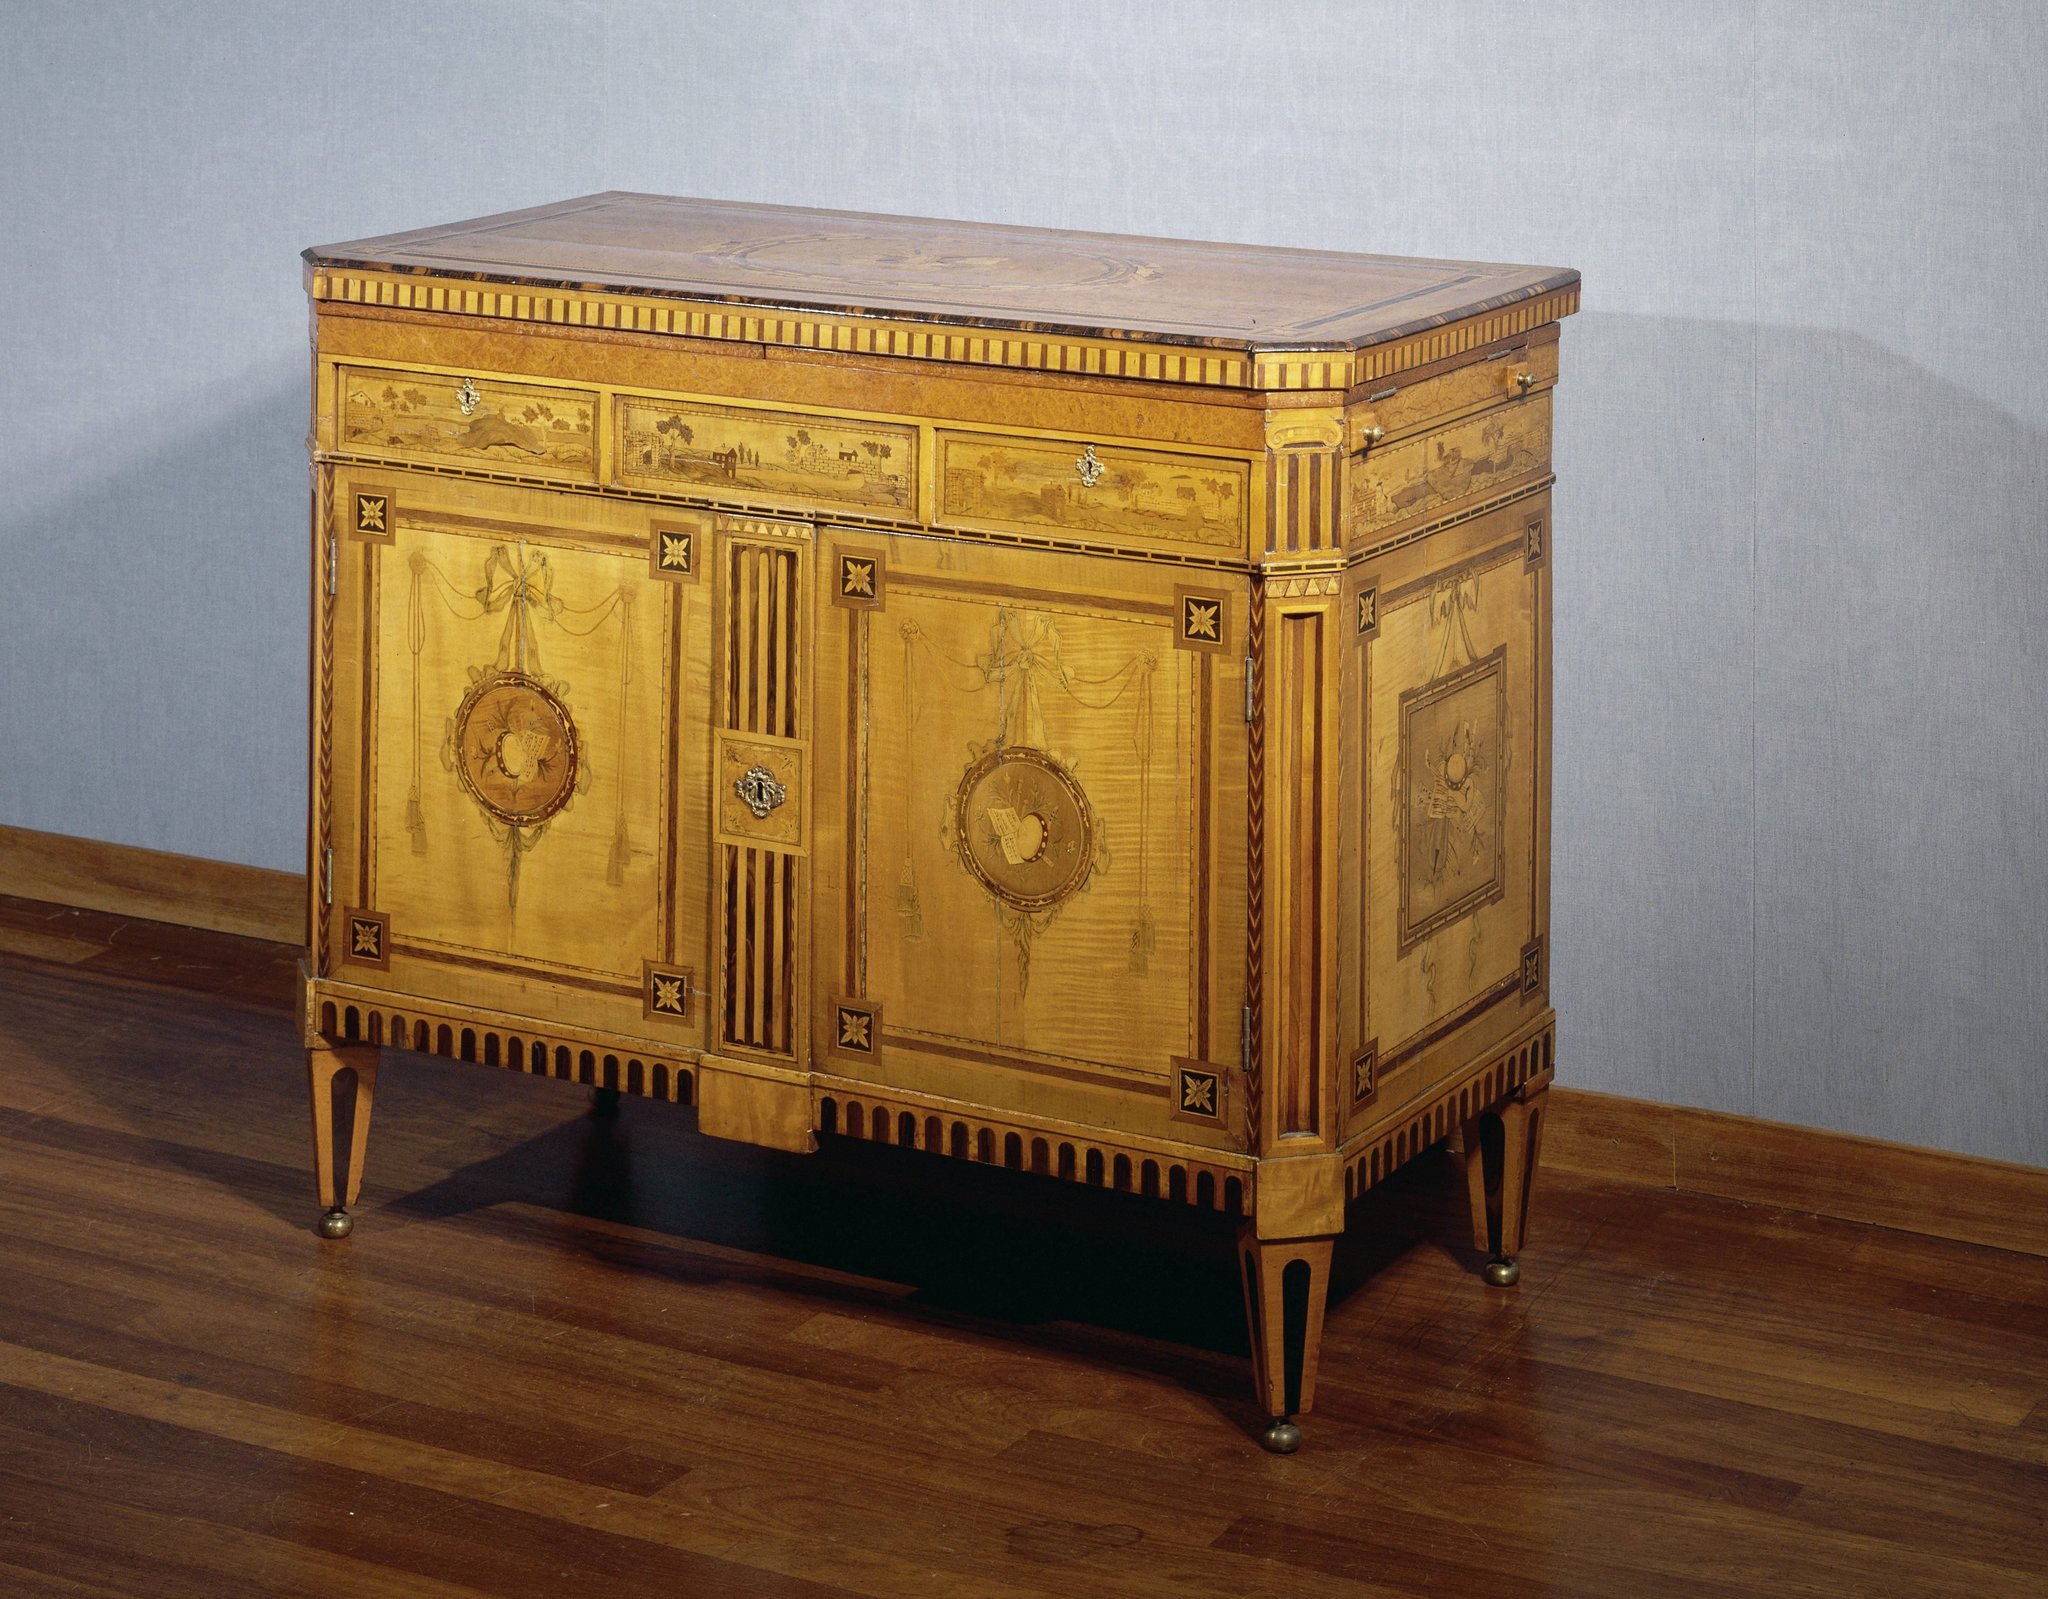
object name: case furniture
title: Buffet met opklapbaar blad. Marqueterieversiering met muziektropheeën in medaillons met strikken en koord.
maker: Anonymous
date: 1780-1795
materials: copper, wood, tin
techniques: marquetry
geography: netherlands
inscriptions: mark: ‘viermerk waarboven een gekroonde X’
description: Sideboard. Oak, veneered with various woods, the top can be raised to reveal a fountain and basin of pewter. Netherlands, c. 1780 - 1795.